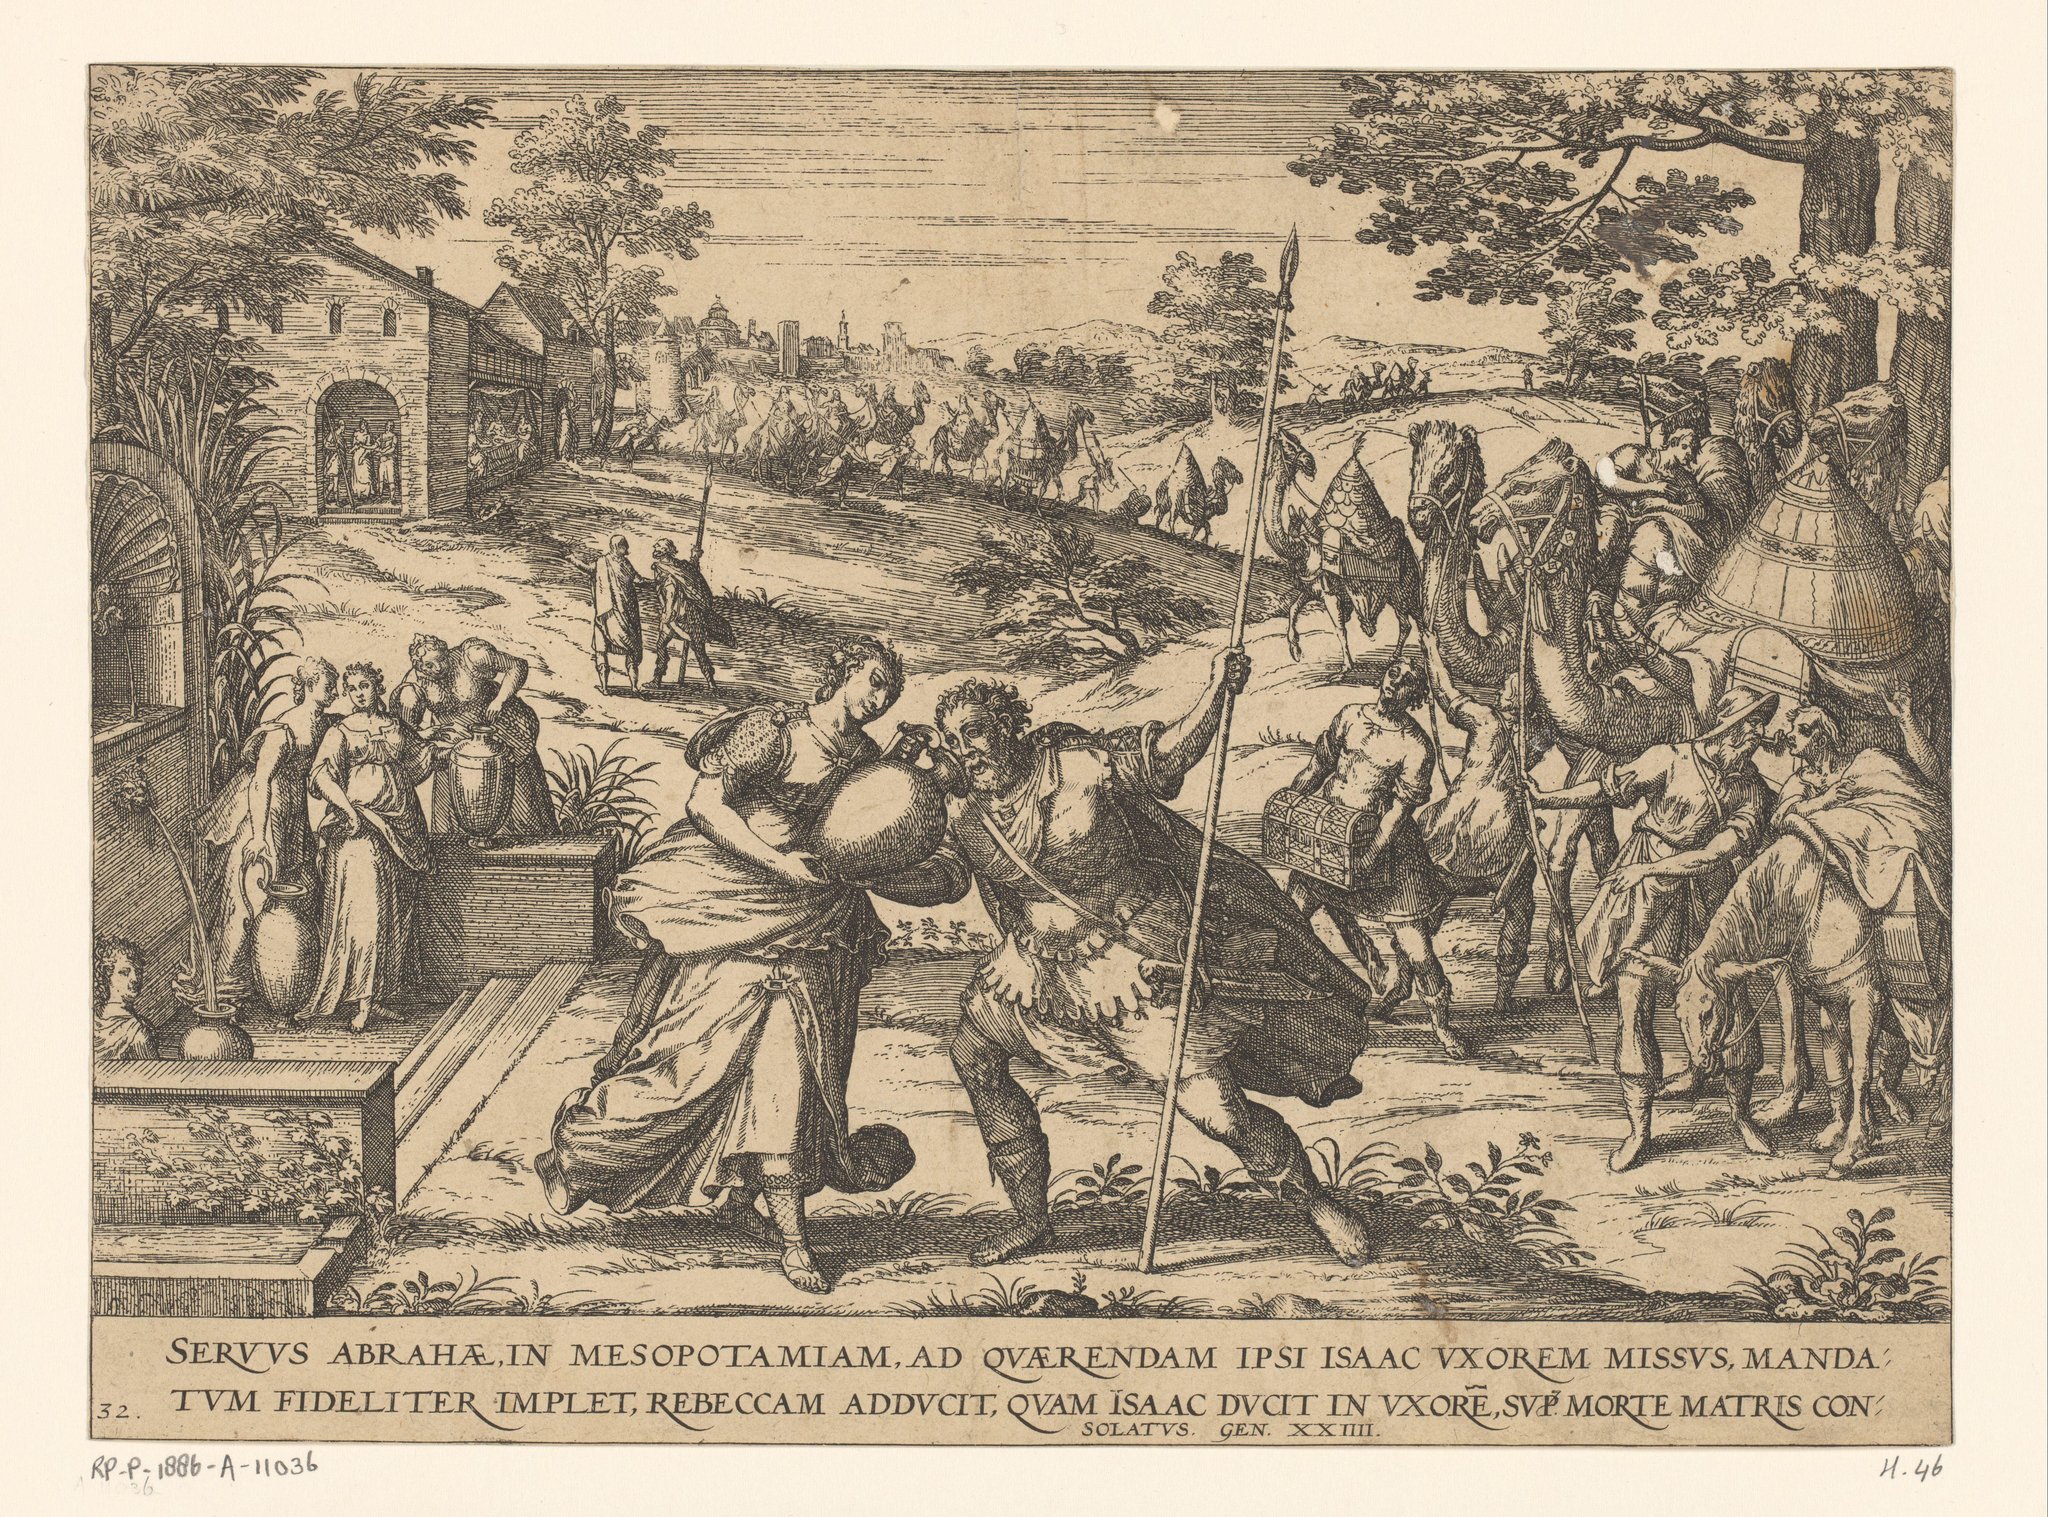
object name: print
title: Rebekka bij de bron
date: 1577-1627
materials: paper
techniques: etching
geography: cologne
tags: the meeting at the well: eliezer sees rebekah coming with a pitcher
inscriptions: collector's mark: Lugt 2228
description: Rebekka biedt Eliëzer haar kruik aan bij de bron. Rechts de kamelen en het gevolg van Eliëzer met geschenken. Onderaan een verwijzing in het Latijn naar de Bijbeltekst in Gen. 24.